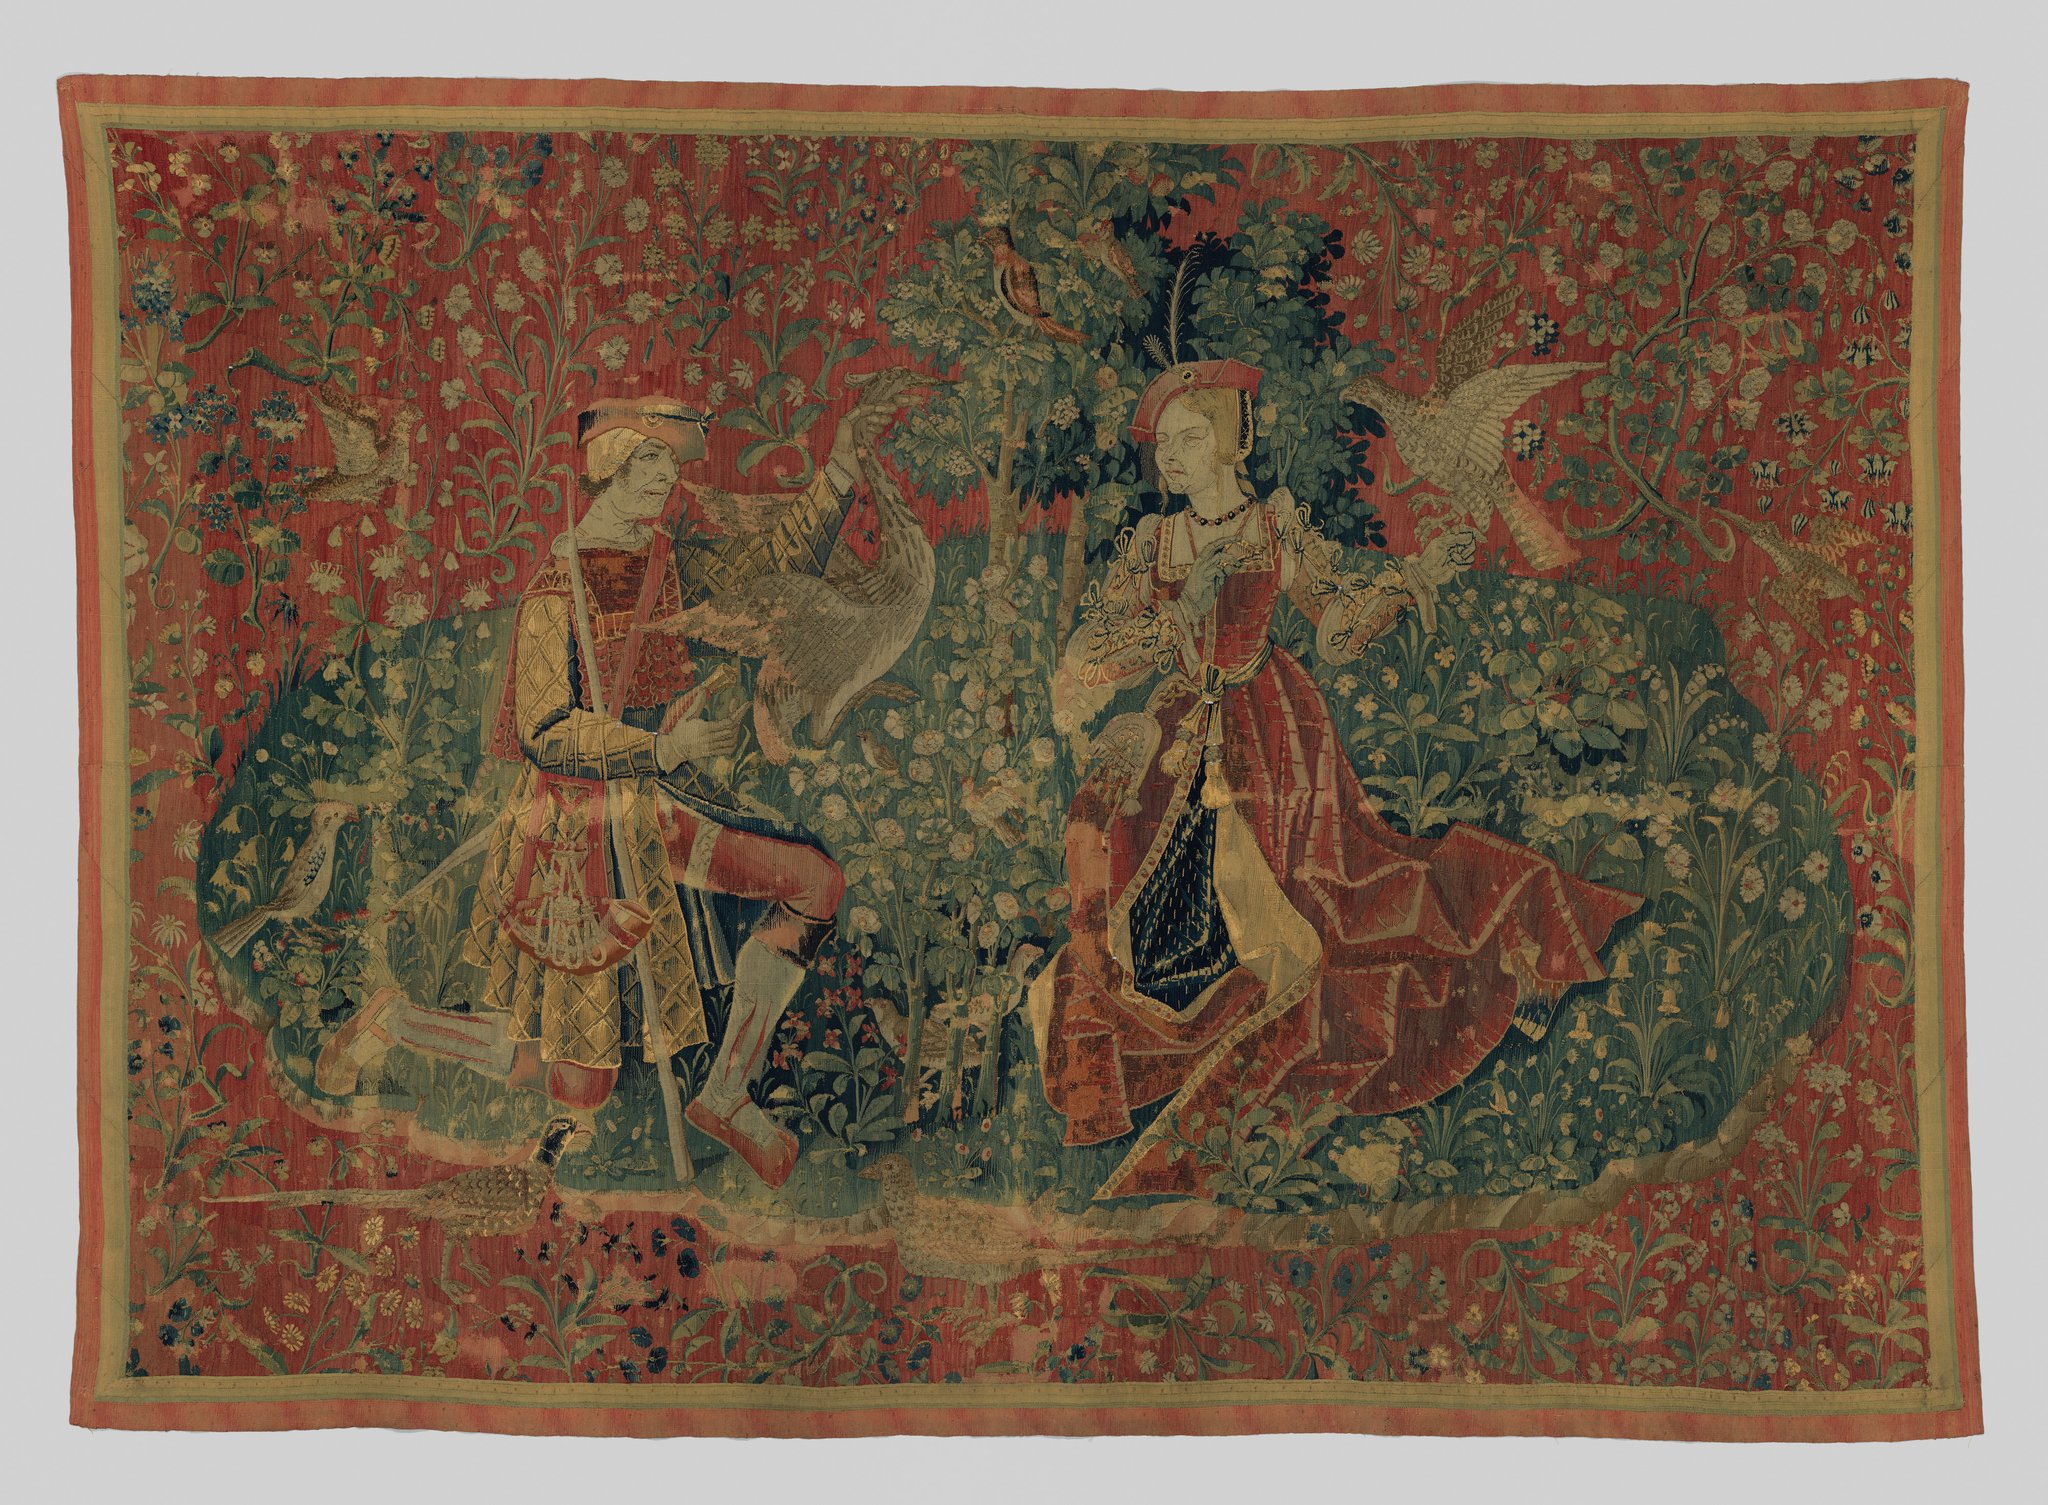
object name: tapestry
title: Huntsman Presenting a Captured Heron to a Lady Falconer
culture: south netherlandish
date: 1500-1530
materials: silk, wool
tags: falcons,women